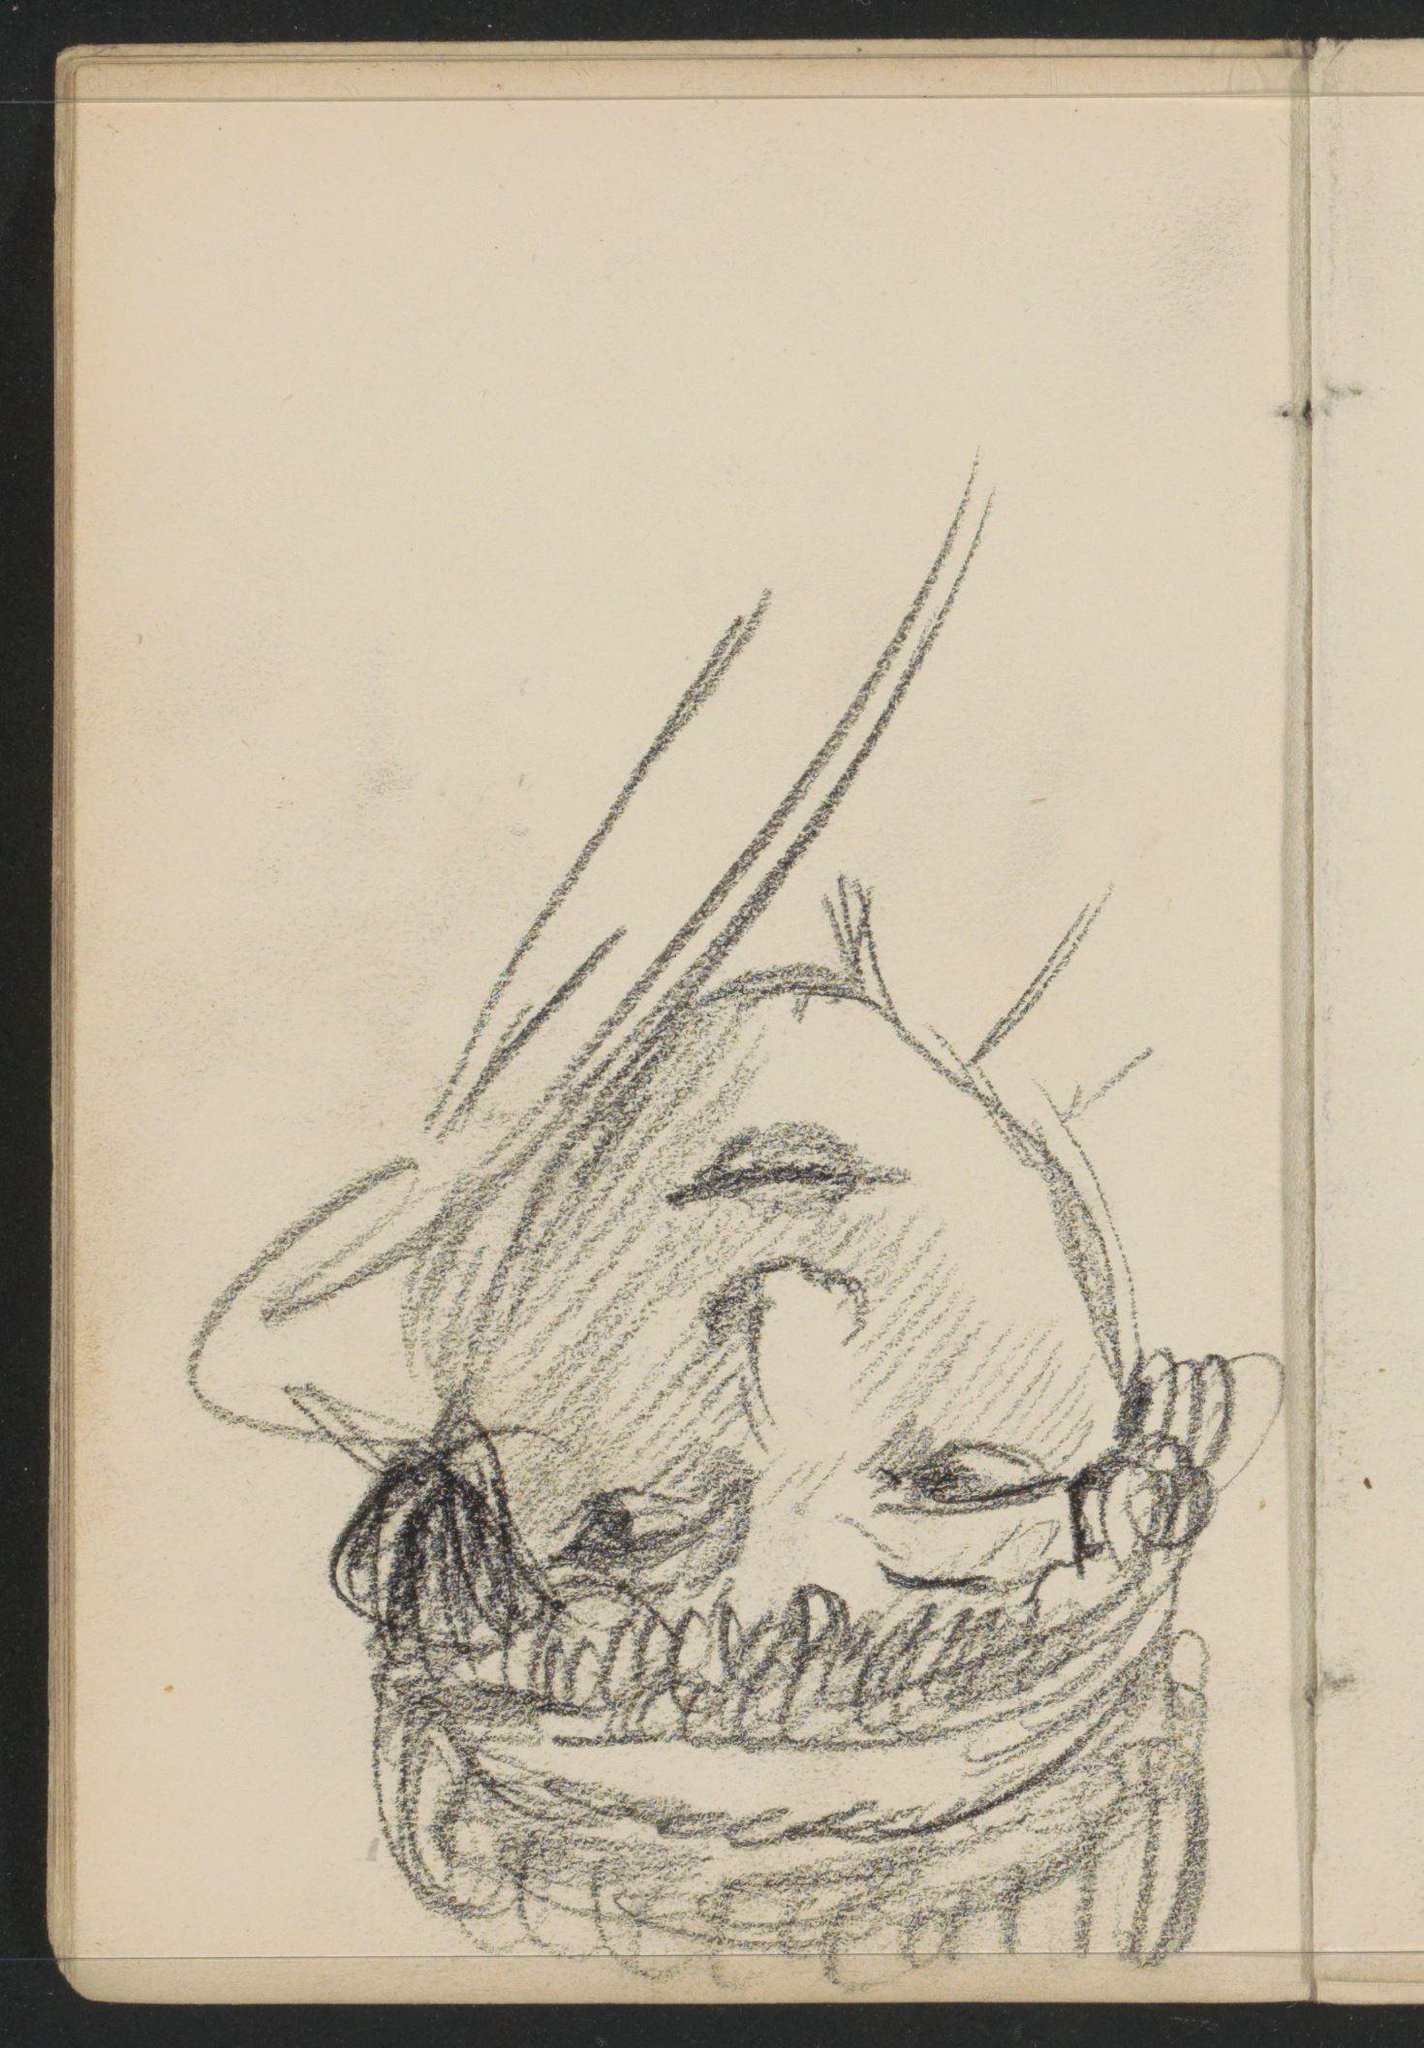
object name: sketchbook leaf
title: Vrouwenhoofd met haarband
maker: isaac israels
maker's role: draughtsman, painter, print maker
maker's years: 1865-1934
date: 1887-1934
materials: chalk, paper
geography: paris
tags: head-gear (+ women's clothes), head (human) - aa - female human figure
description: Pagina 13 uit schetsboek XXXIX met 51 pagina's.